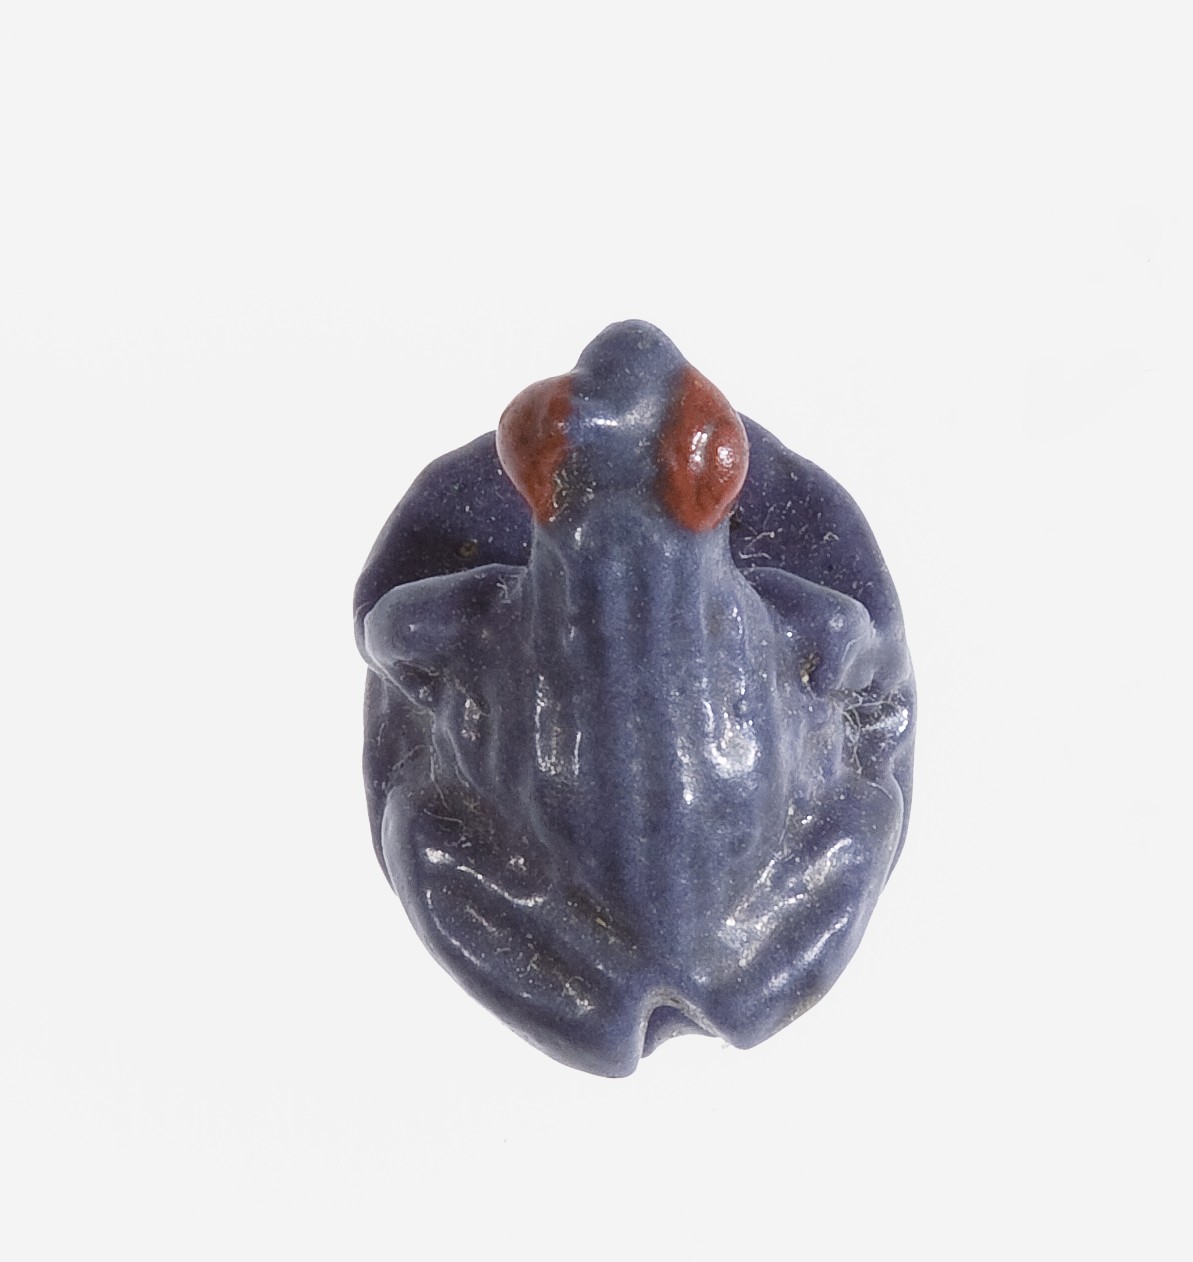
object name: stamp seal, frog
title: Frog Seal Amulet with a Sa Hieroglyph on the Base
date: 1390-1352 BCE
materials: faience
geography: egypt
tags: hieroglyphs,frogs